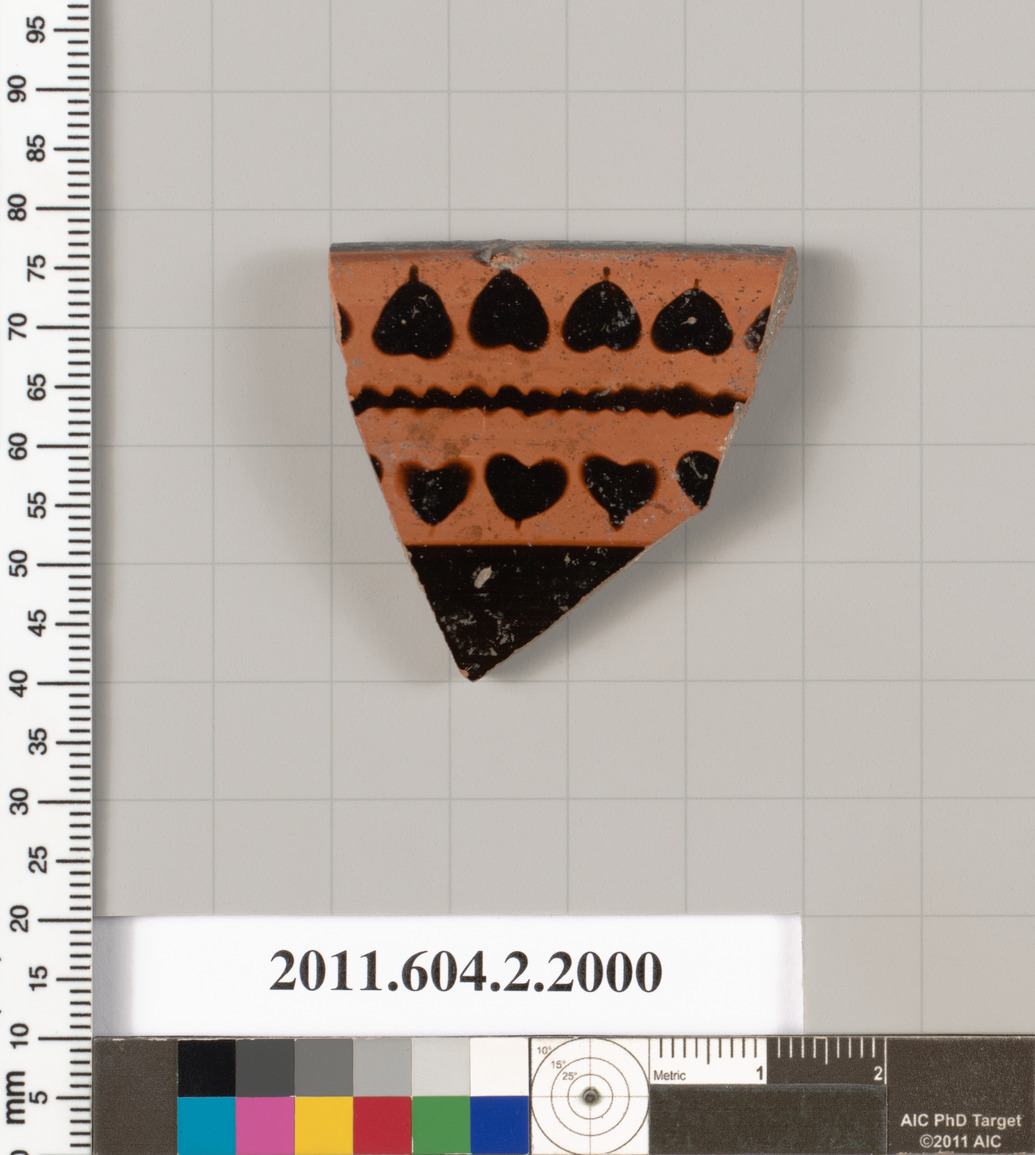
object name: plate fragment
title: Terracotta fragment of a plate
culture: greek, attic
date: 534-501 BCE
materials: terracotta